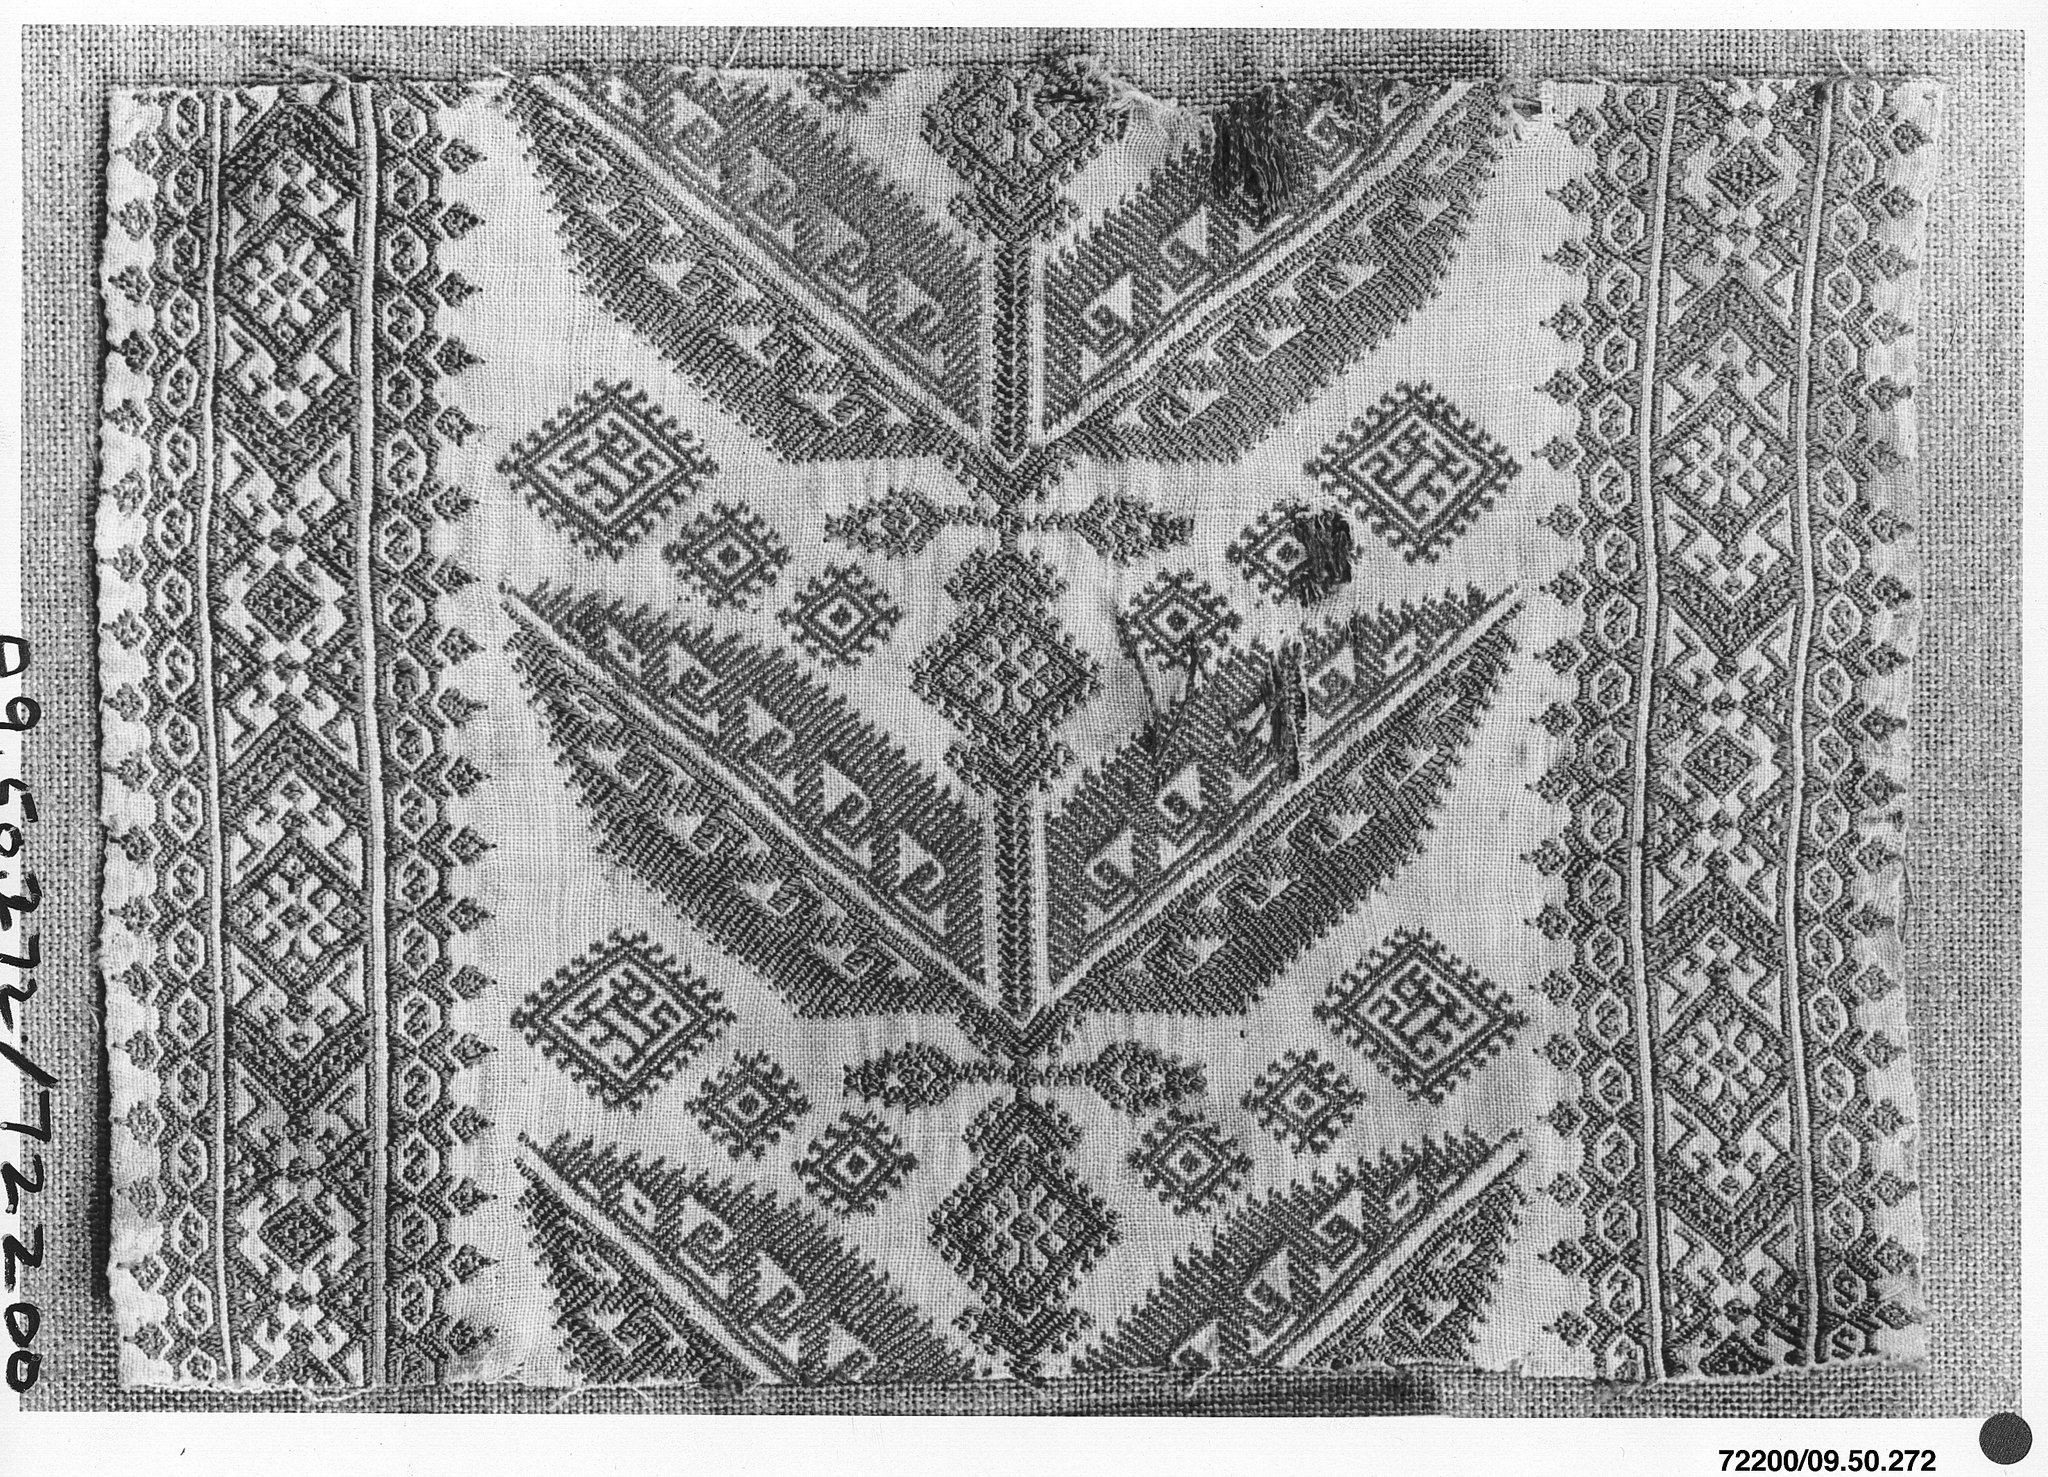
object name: band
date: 1701-1800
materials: cotton